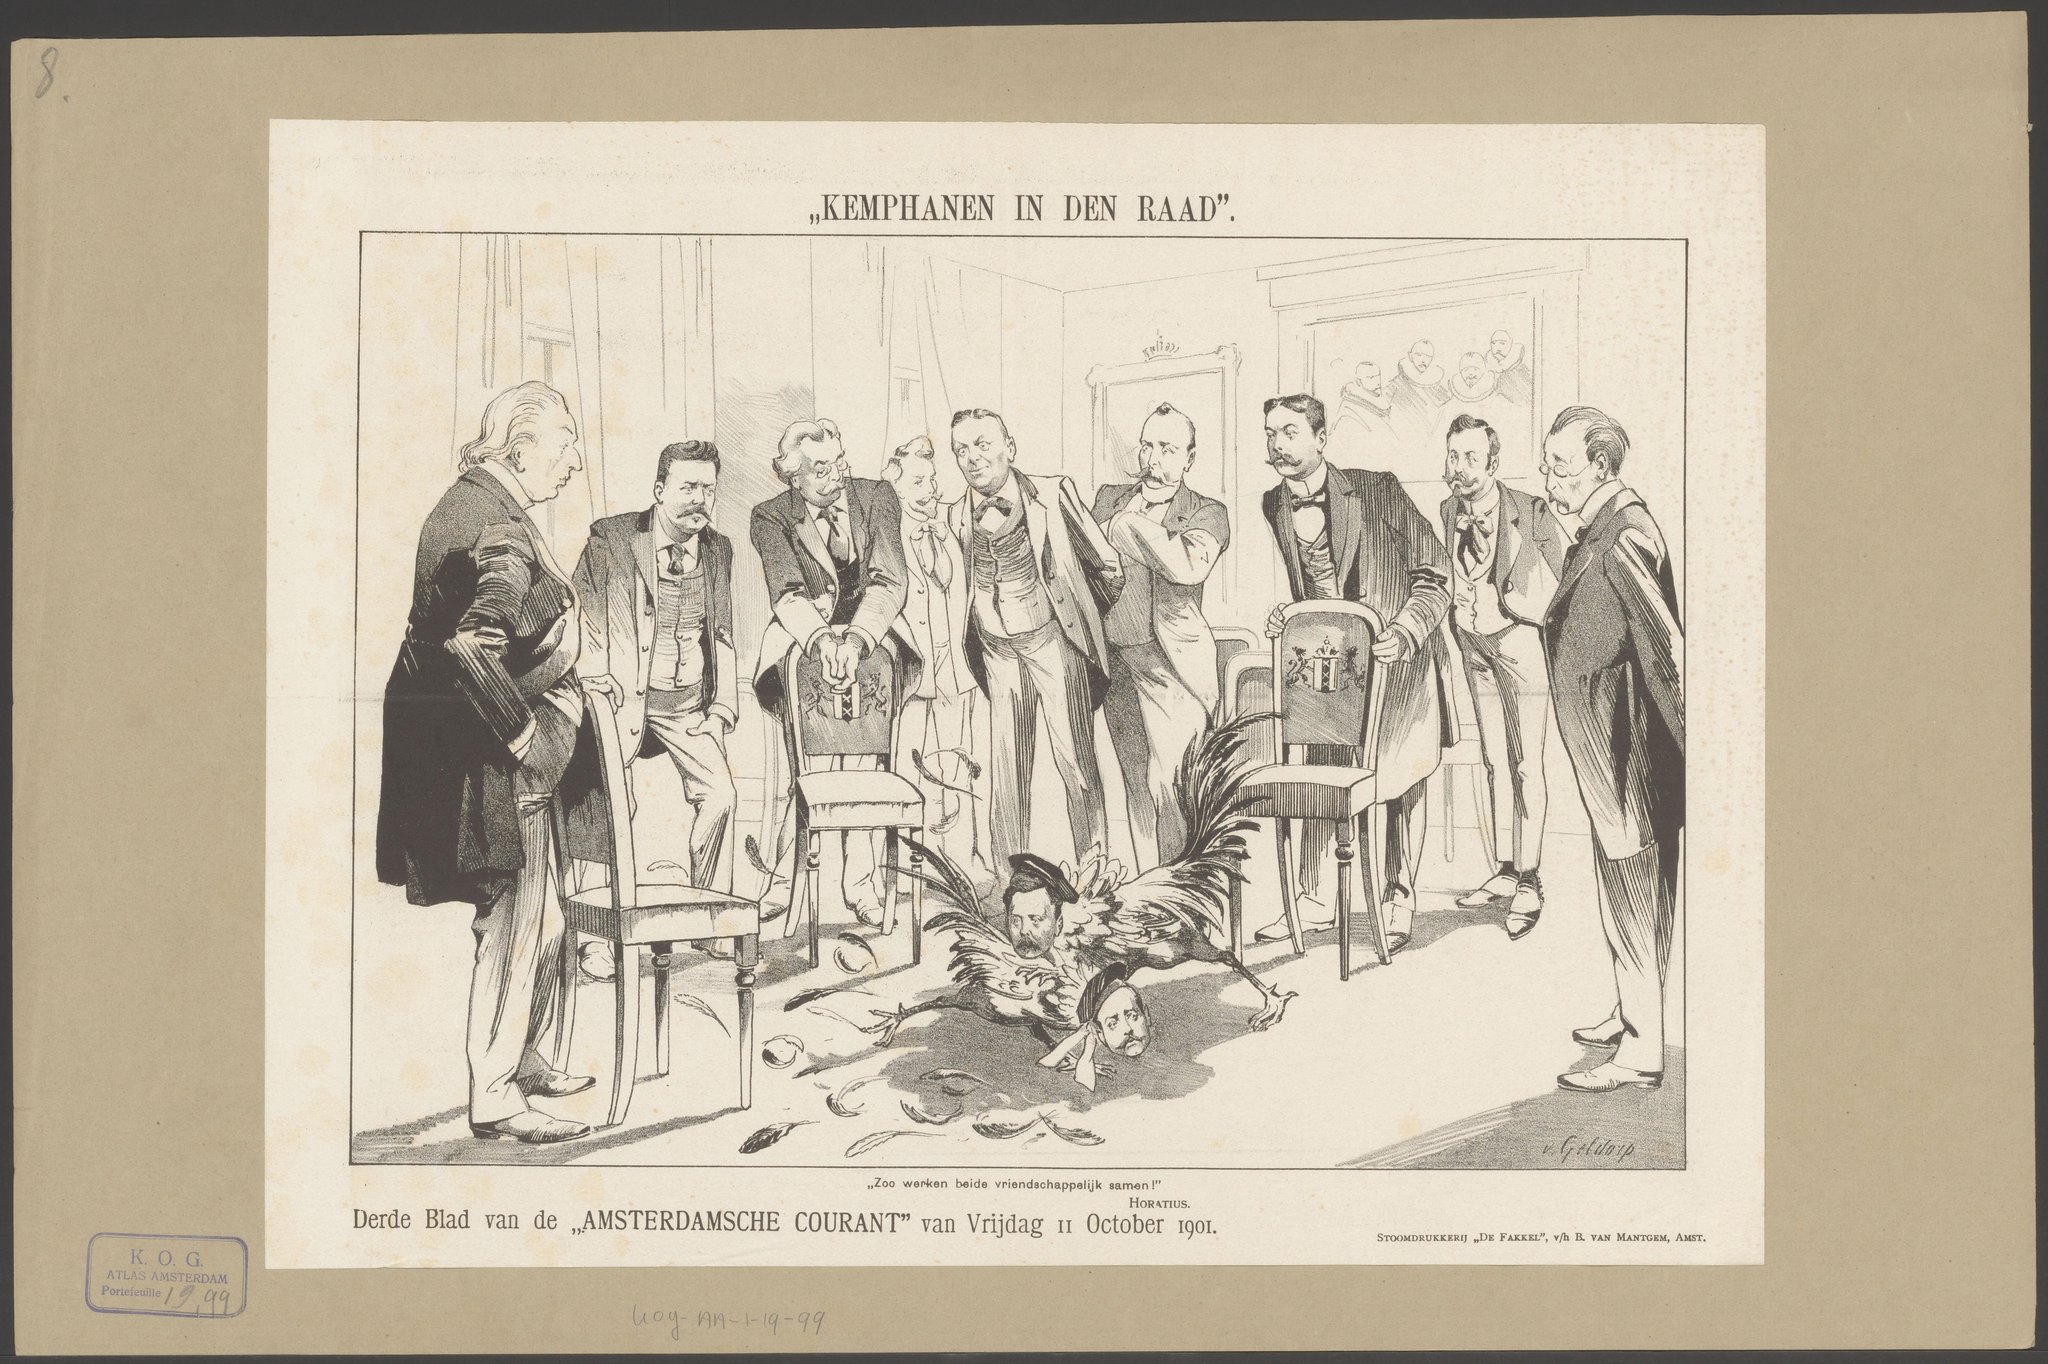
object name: cartoon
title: Kemphanen in den Raad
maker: petrus van geldorp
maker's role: draughtsman, print maker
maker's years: 1872-1939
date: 1901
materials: paper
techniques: letterpress printing, lithograph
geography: amsterdam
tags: city council, political caricatures and satires, amsterdam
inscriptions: collector's mark: ‘19,99’ Lugt 1641b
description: Onderwerpsrubriek binnen de Atlas Amsterdam: Herinneringen aan regeringsleden en hunne huisgezinnen [na 1800].